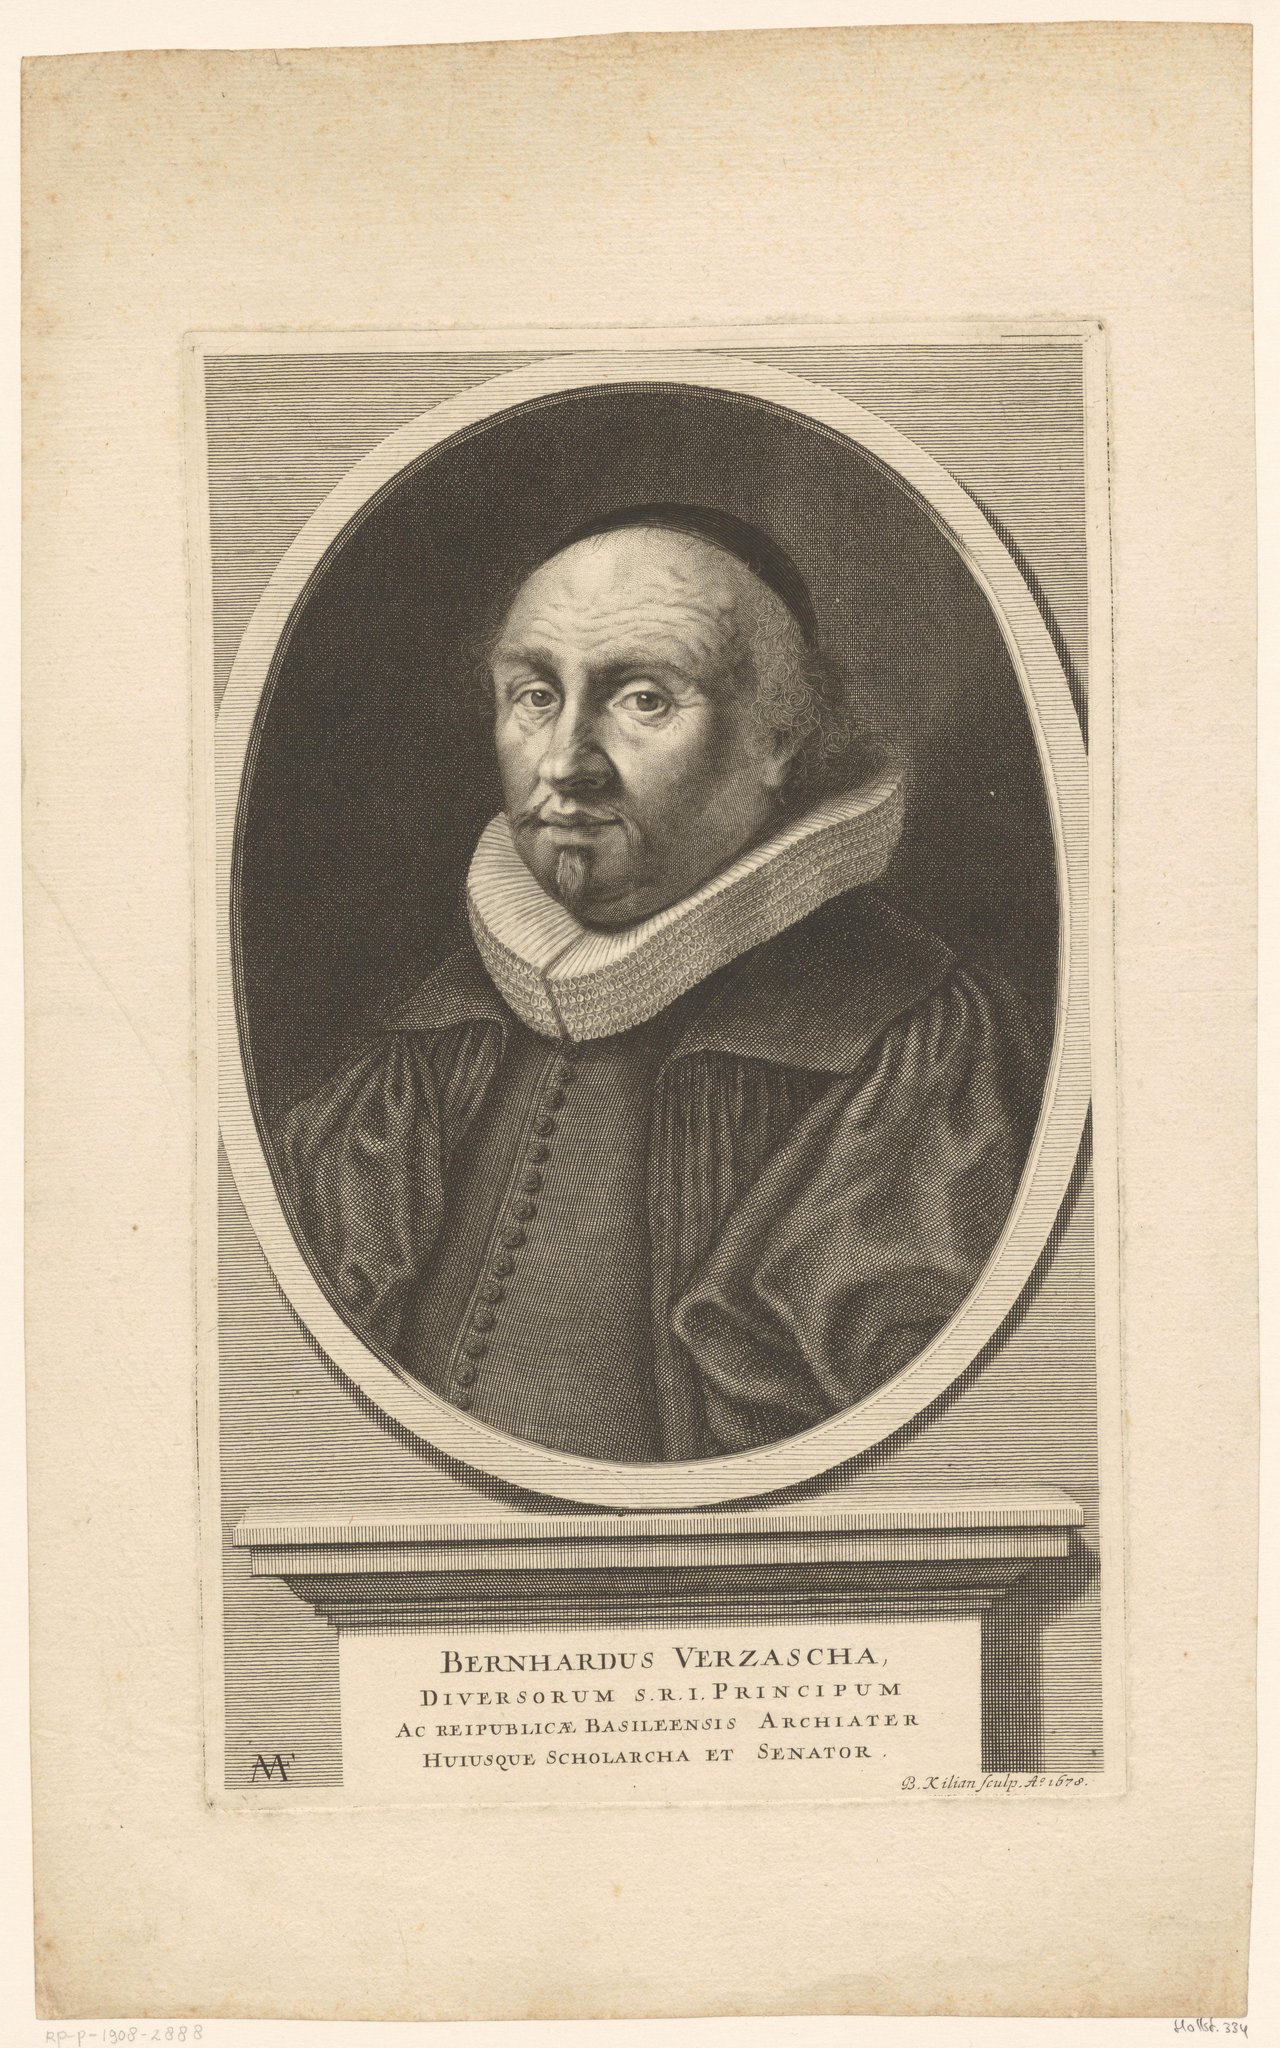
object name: print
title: Portret van Bernard Verzascha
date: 1678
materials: paper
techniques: engraving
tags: historical persons, physician, doctor (+ portrait of scholar, scientist)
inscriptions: collector's mark: Lugt 2228